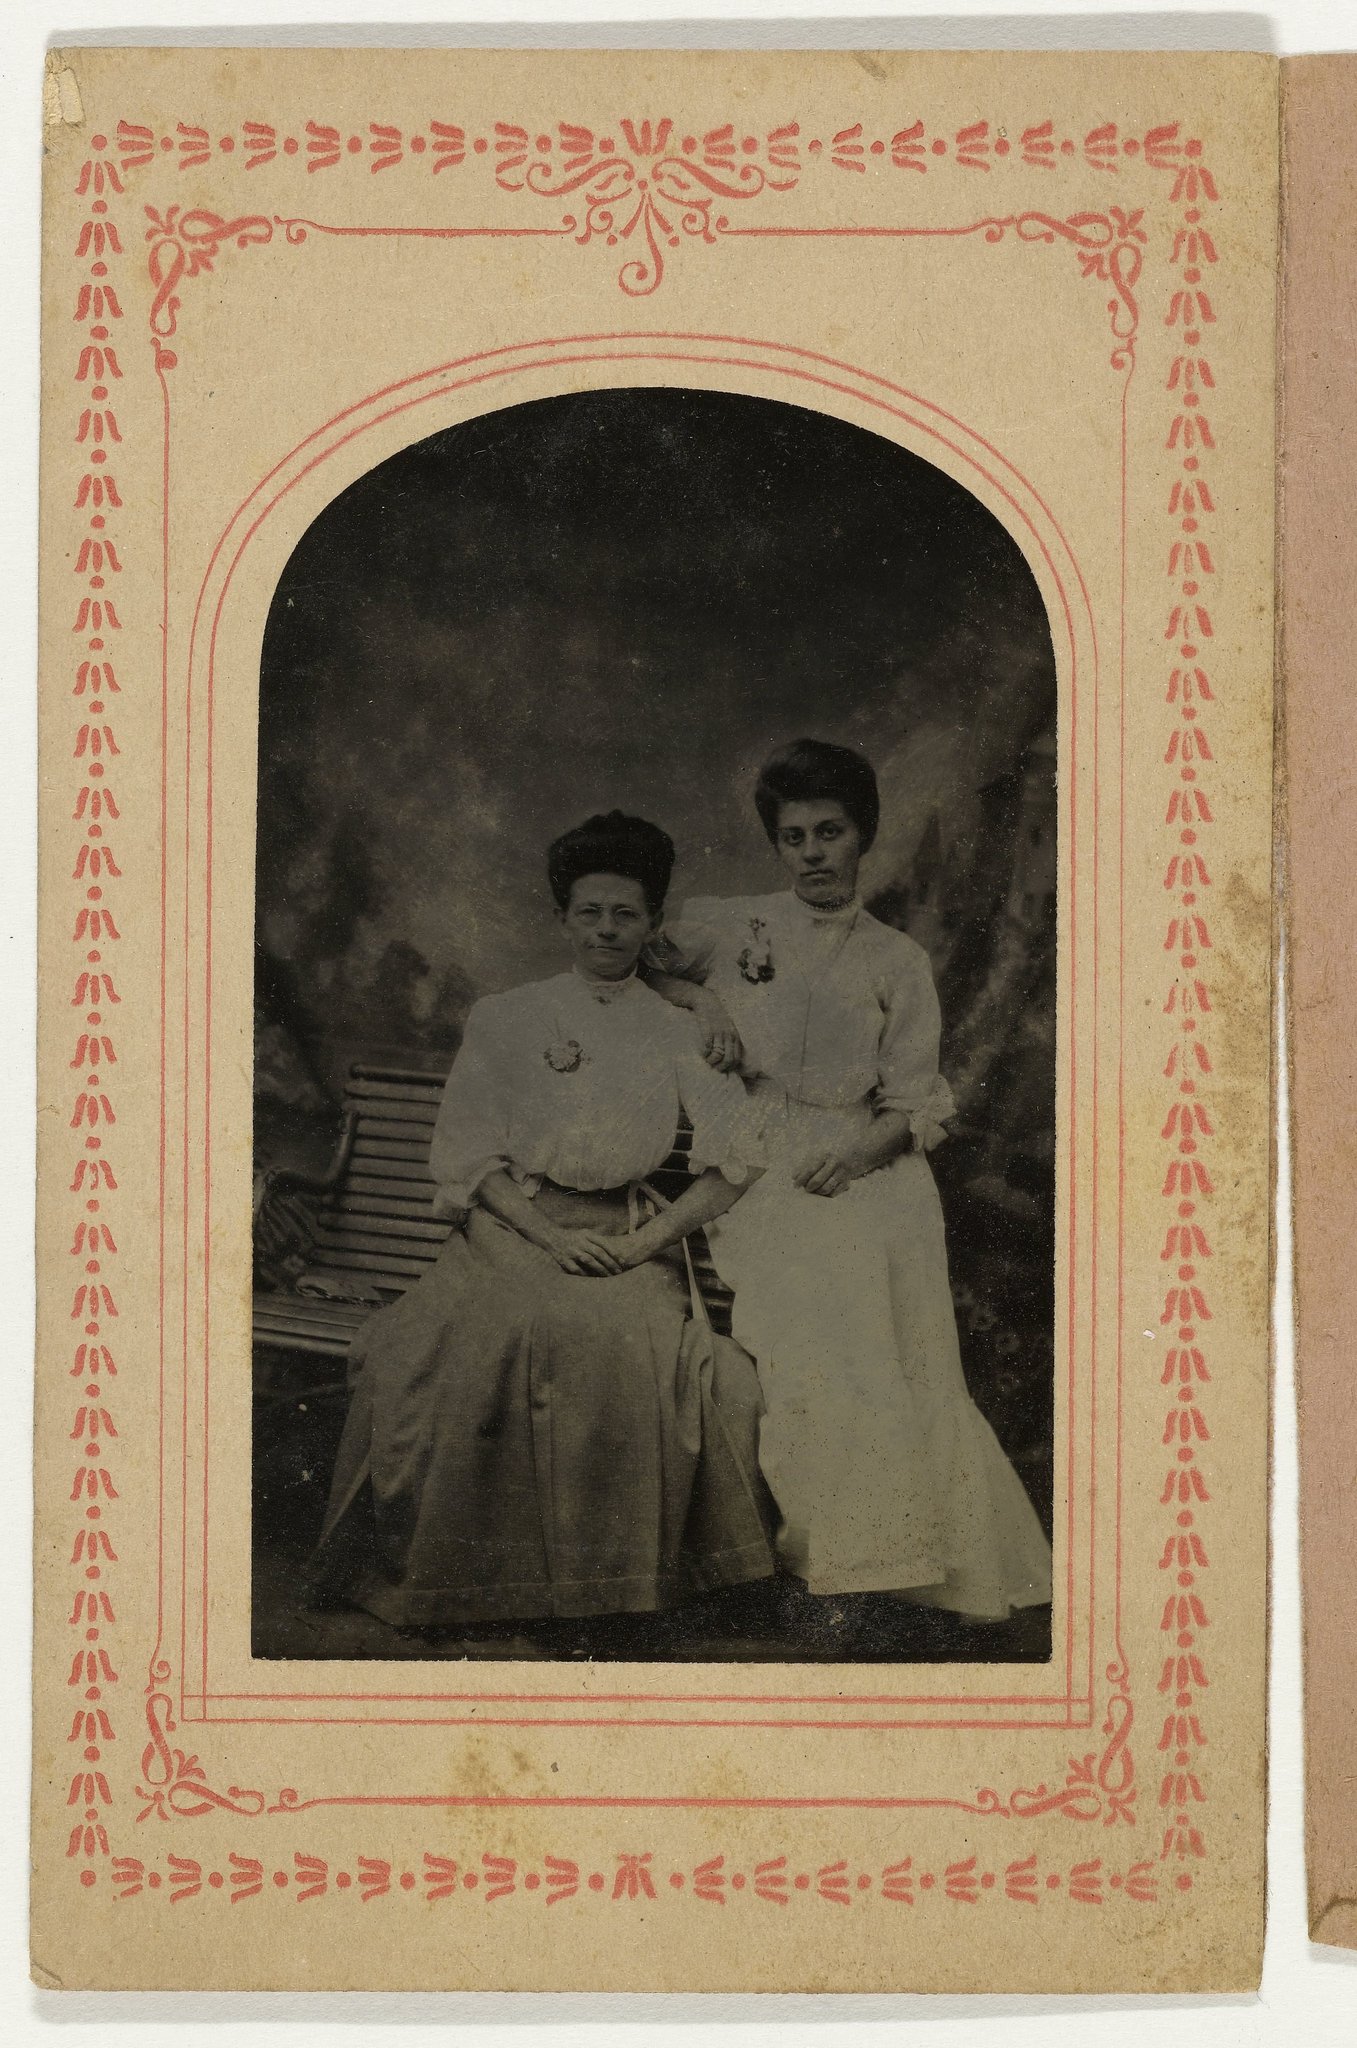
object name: photograph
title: Portrait of a woman and a girl in front of a painted backdrop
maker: w.h. pearce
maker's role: fotograaf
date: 1890-1910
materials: metal, paper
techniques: ferrotyping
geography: united states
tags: anonymous historical person portrayed - bb - woman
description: Portret van een vrouw en een meisje voor een geschilderd achtergronddoek. In een papieren passepartout met in autotypie een foto van de ferrotypietent.